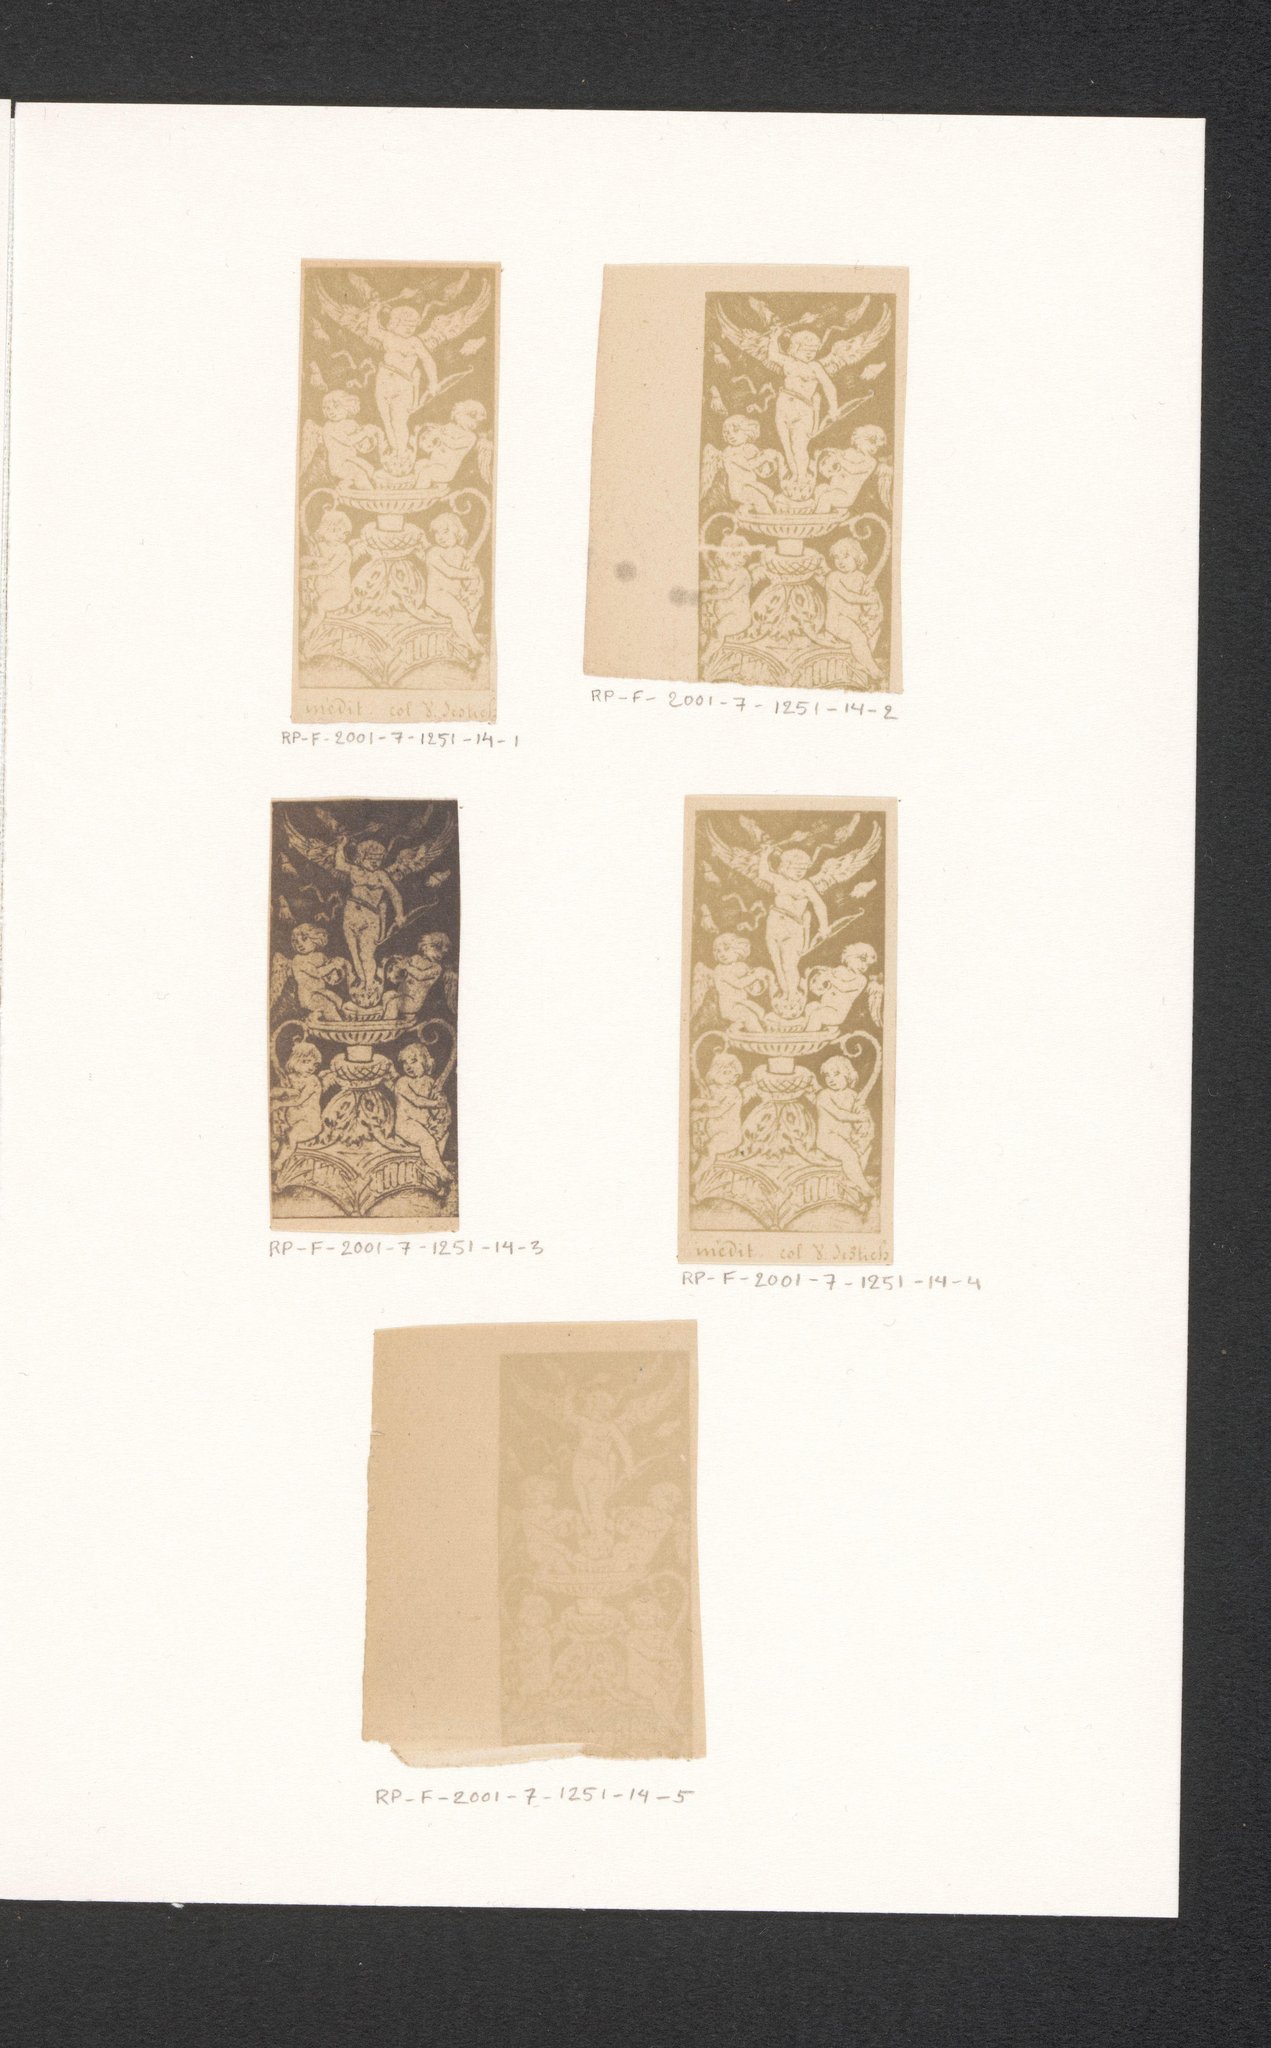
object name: reproduction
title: Fotoreproductie van een prent van de triomf van de liefde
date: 1852-1857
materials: photographic support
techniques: salted paper print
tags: vase ~ ornament, cupids: 'amores', 'amoretti', 'putti'